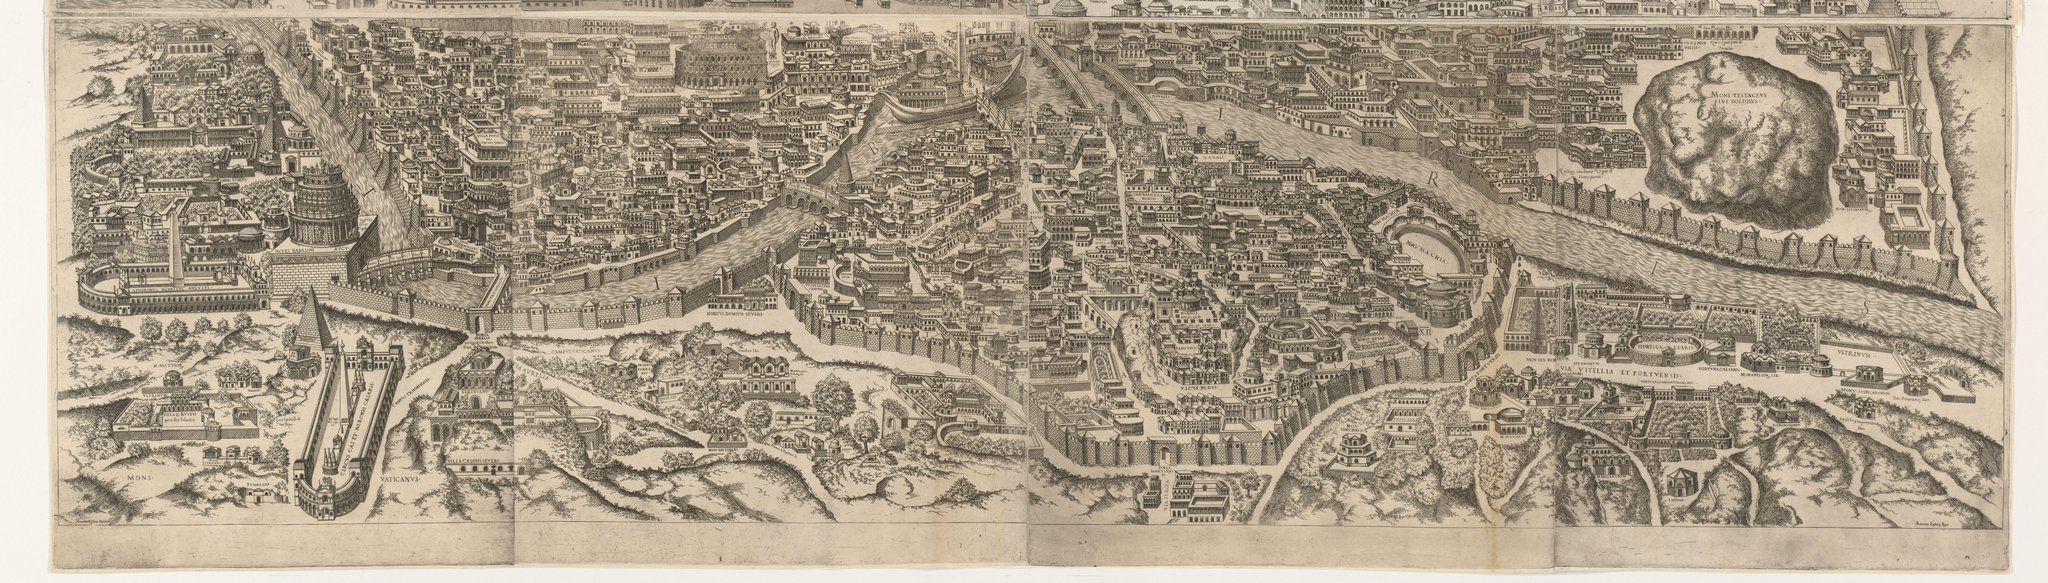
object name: area plan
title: Effigies antiquae Romae ex vestigiis aedificiorum ruinis (...)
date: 1561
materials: paper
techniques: engraving, etching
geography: rome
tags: city-view, and landscape with man-made constructions, rome